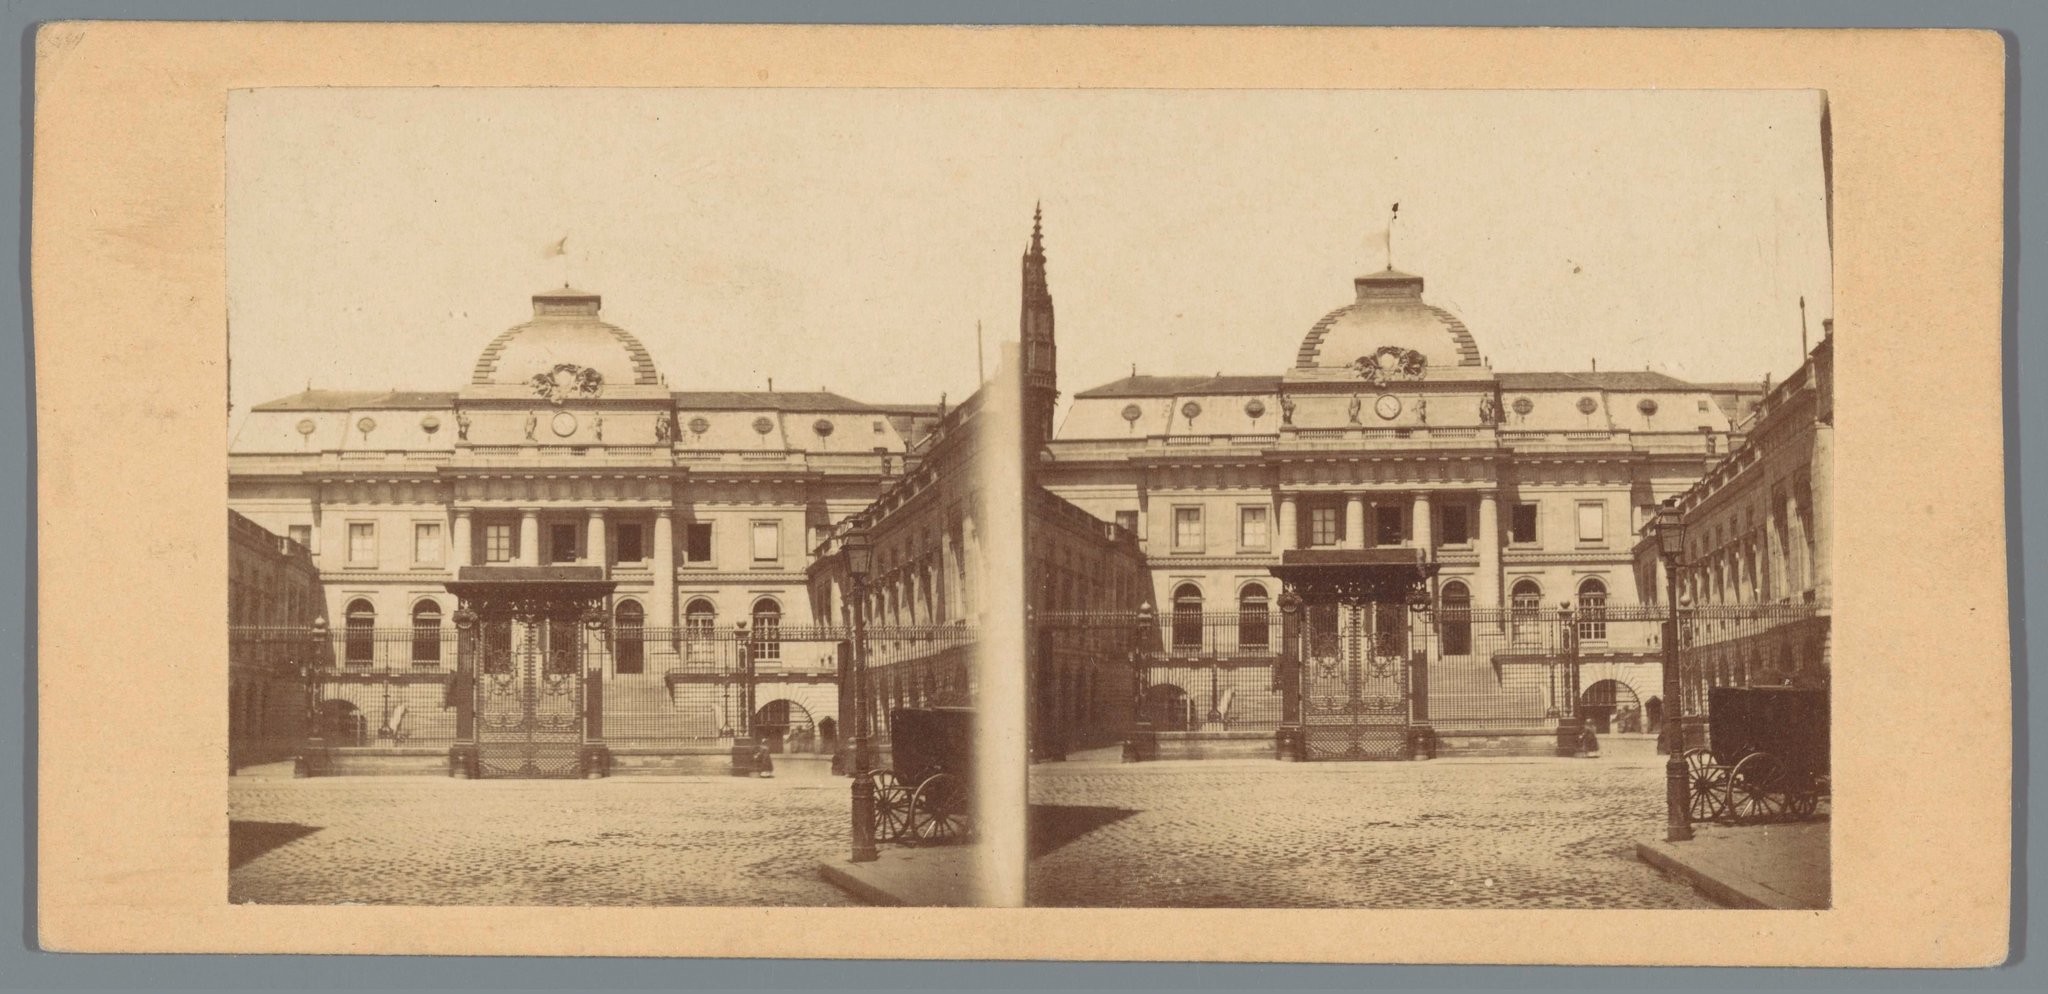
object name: stereograph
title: Gezicht op het Palais de Justice in Parijs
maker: Anonymous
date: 1850-1880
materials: cardboard, photographic support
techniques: albumen print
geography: paris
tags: court building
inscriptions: inscription: ‘R.S. Palais de Justice Paris’, number: ‘A8’